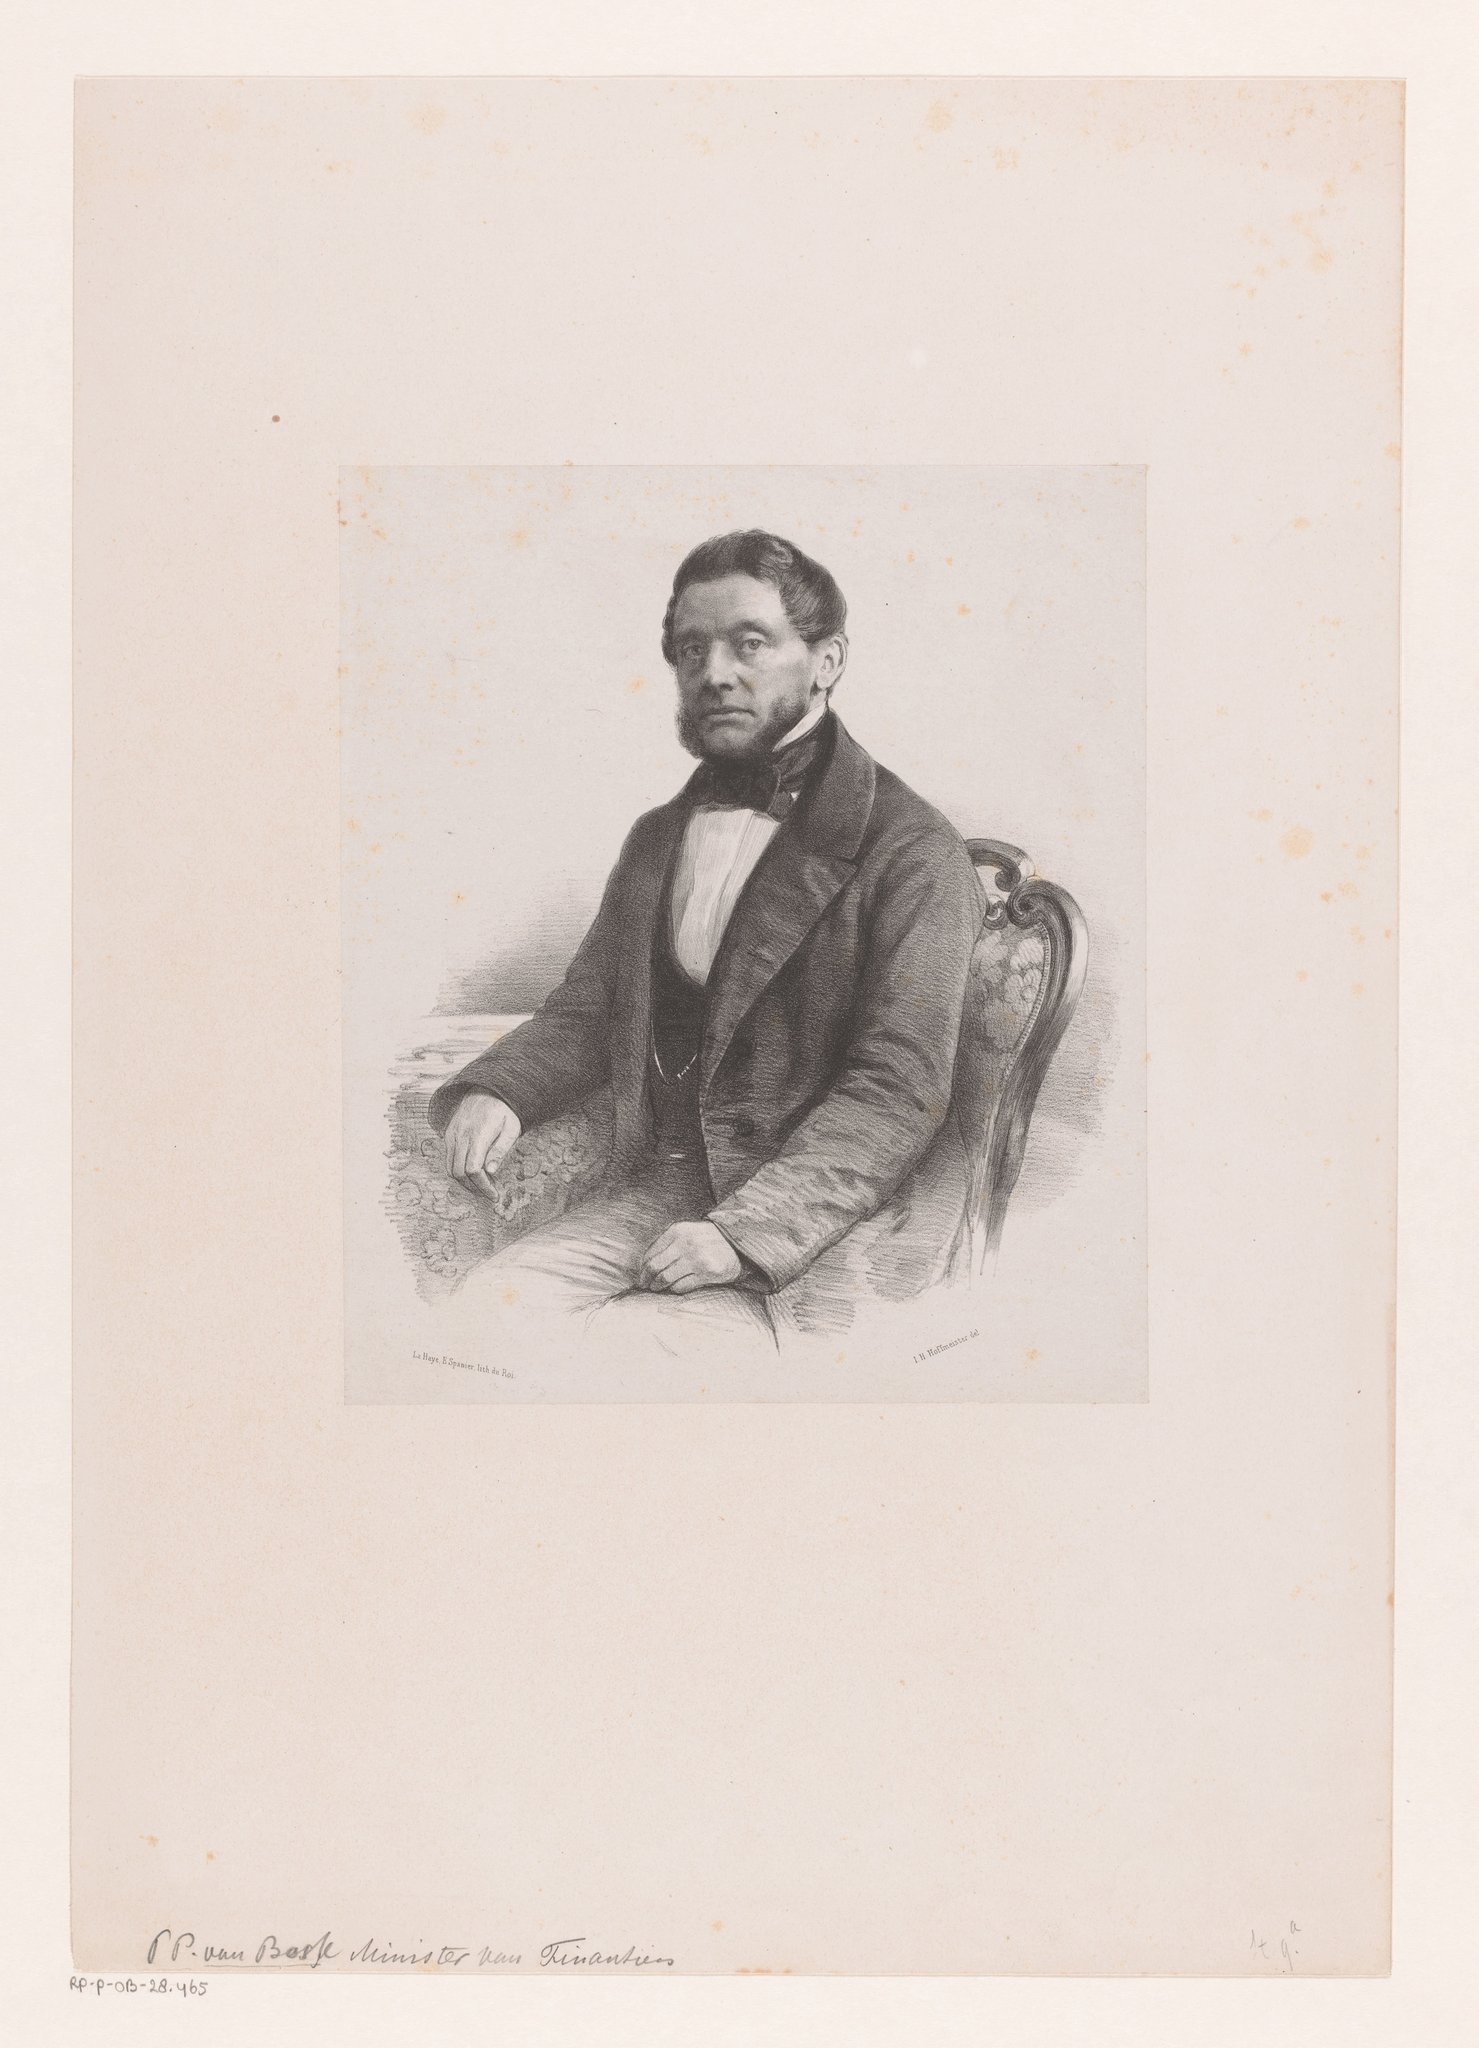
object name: print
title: Portret van Pieter Philip van Bosse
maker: johan hendrik hoffmeister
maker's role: print maker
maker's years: 1823-1904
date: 1851-1879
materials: paper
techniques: lithograph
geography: netherlands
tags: amsterdam, politician, historical persons (+ half-length portrait)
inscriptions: collector's mark: Lugt 2228